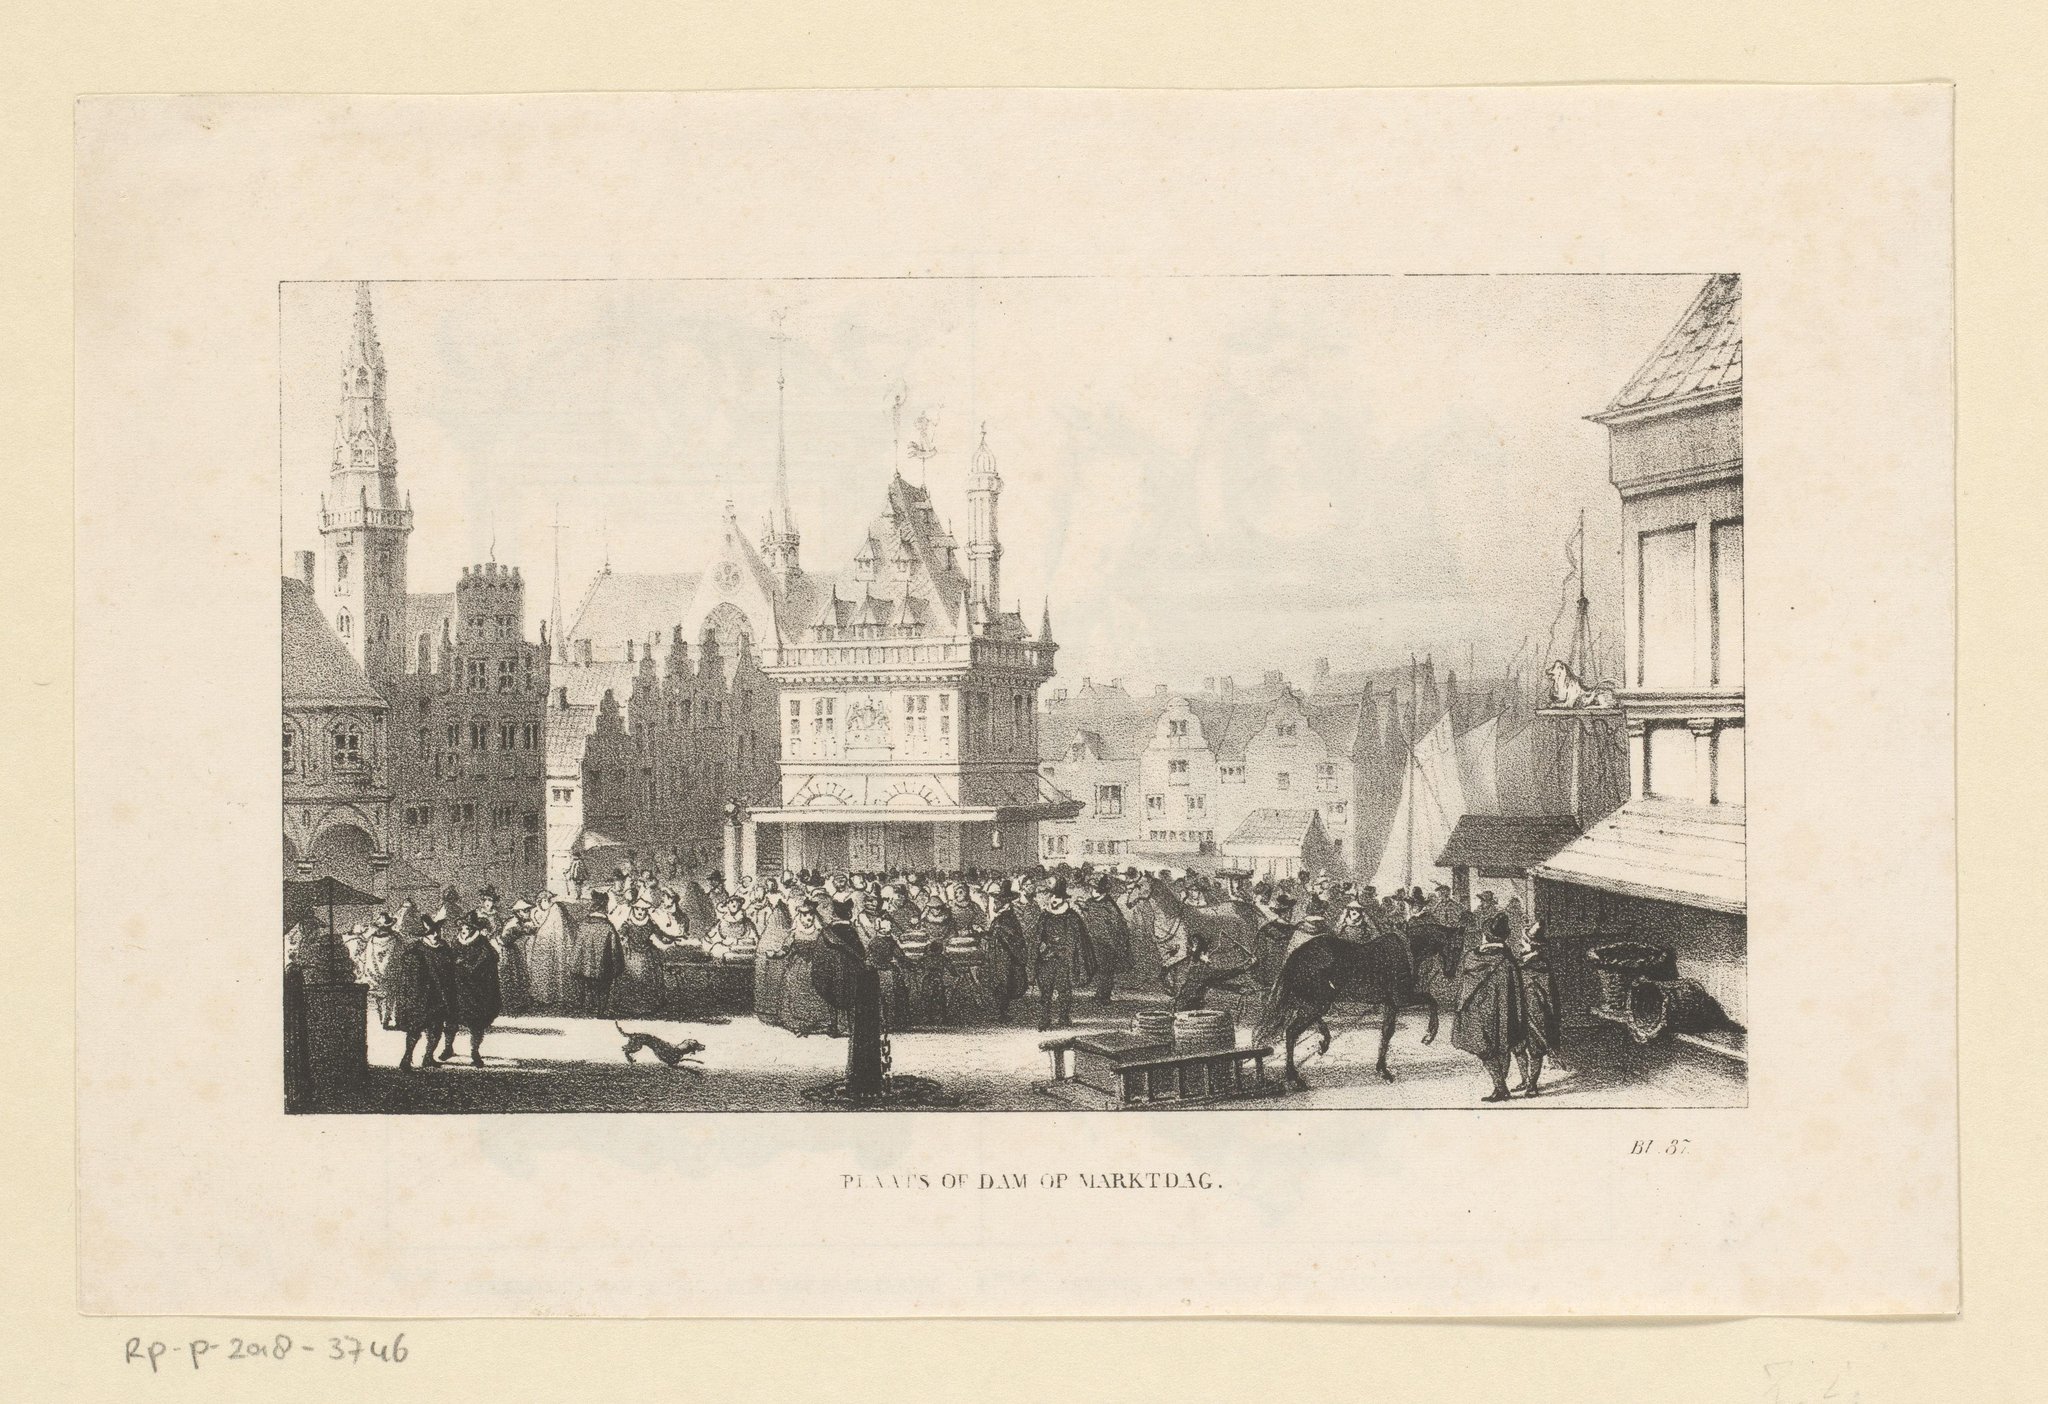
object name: print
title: Gezicht op de markt op de Dam in Amsterdam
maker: Anonymous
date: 1845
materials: paper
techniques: lithograph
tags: market, amsterdam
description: Gezicht op de markt in Amsterdam met op verso het grafteken van viceadmiraal Sweers en het praalgraf van admiraal Jacob van Heemskerk.